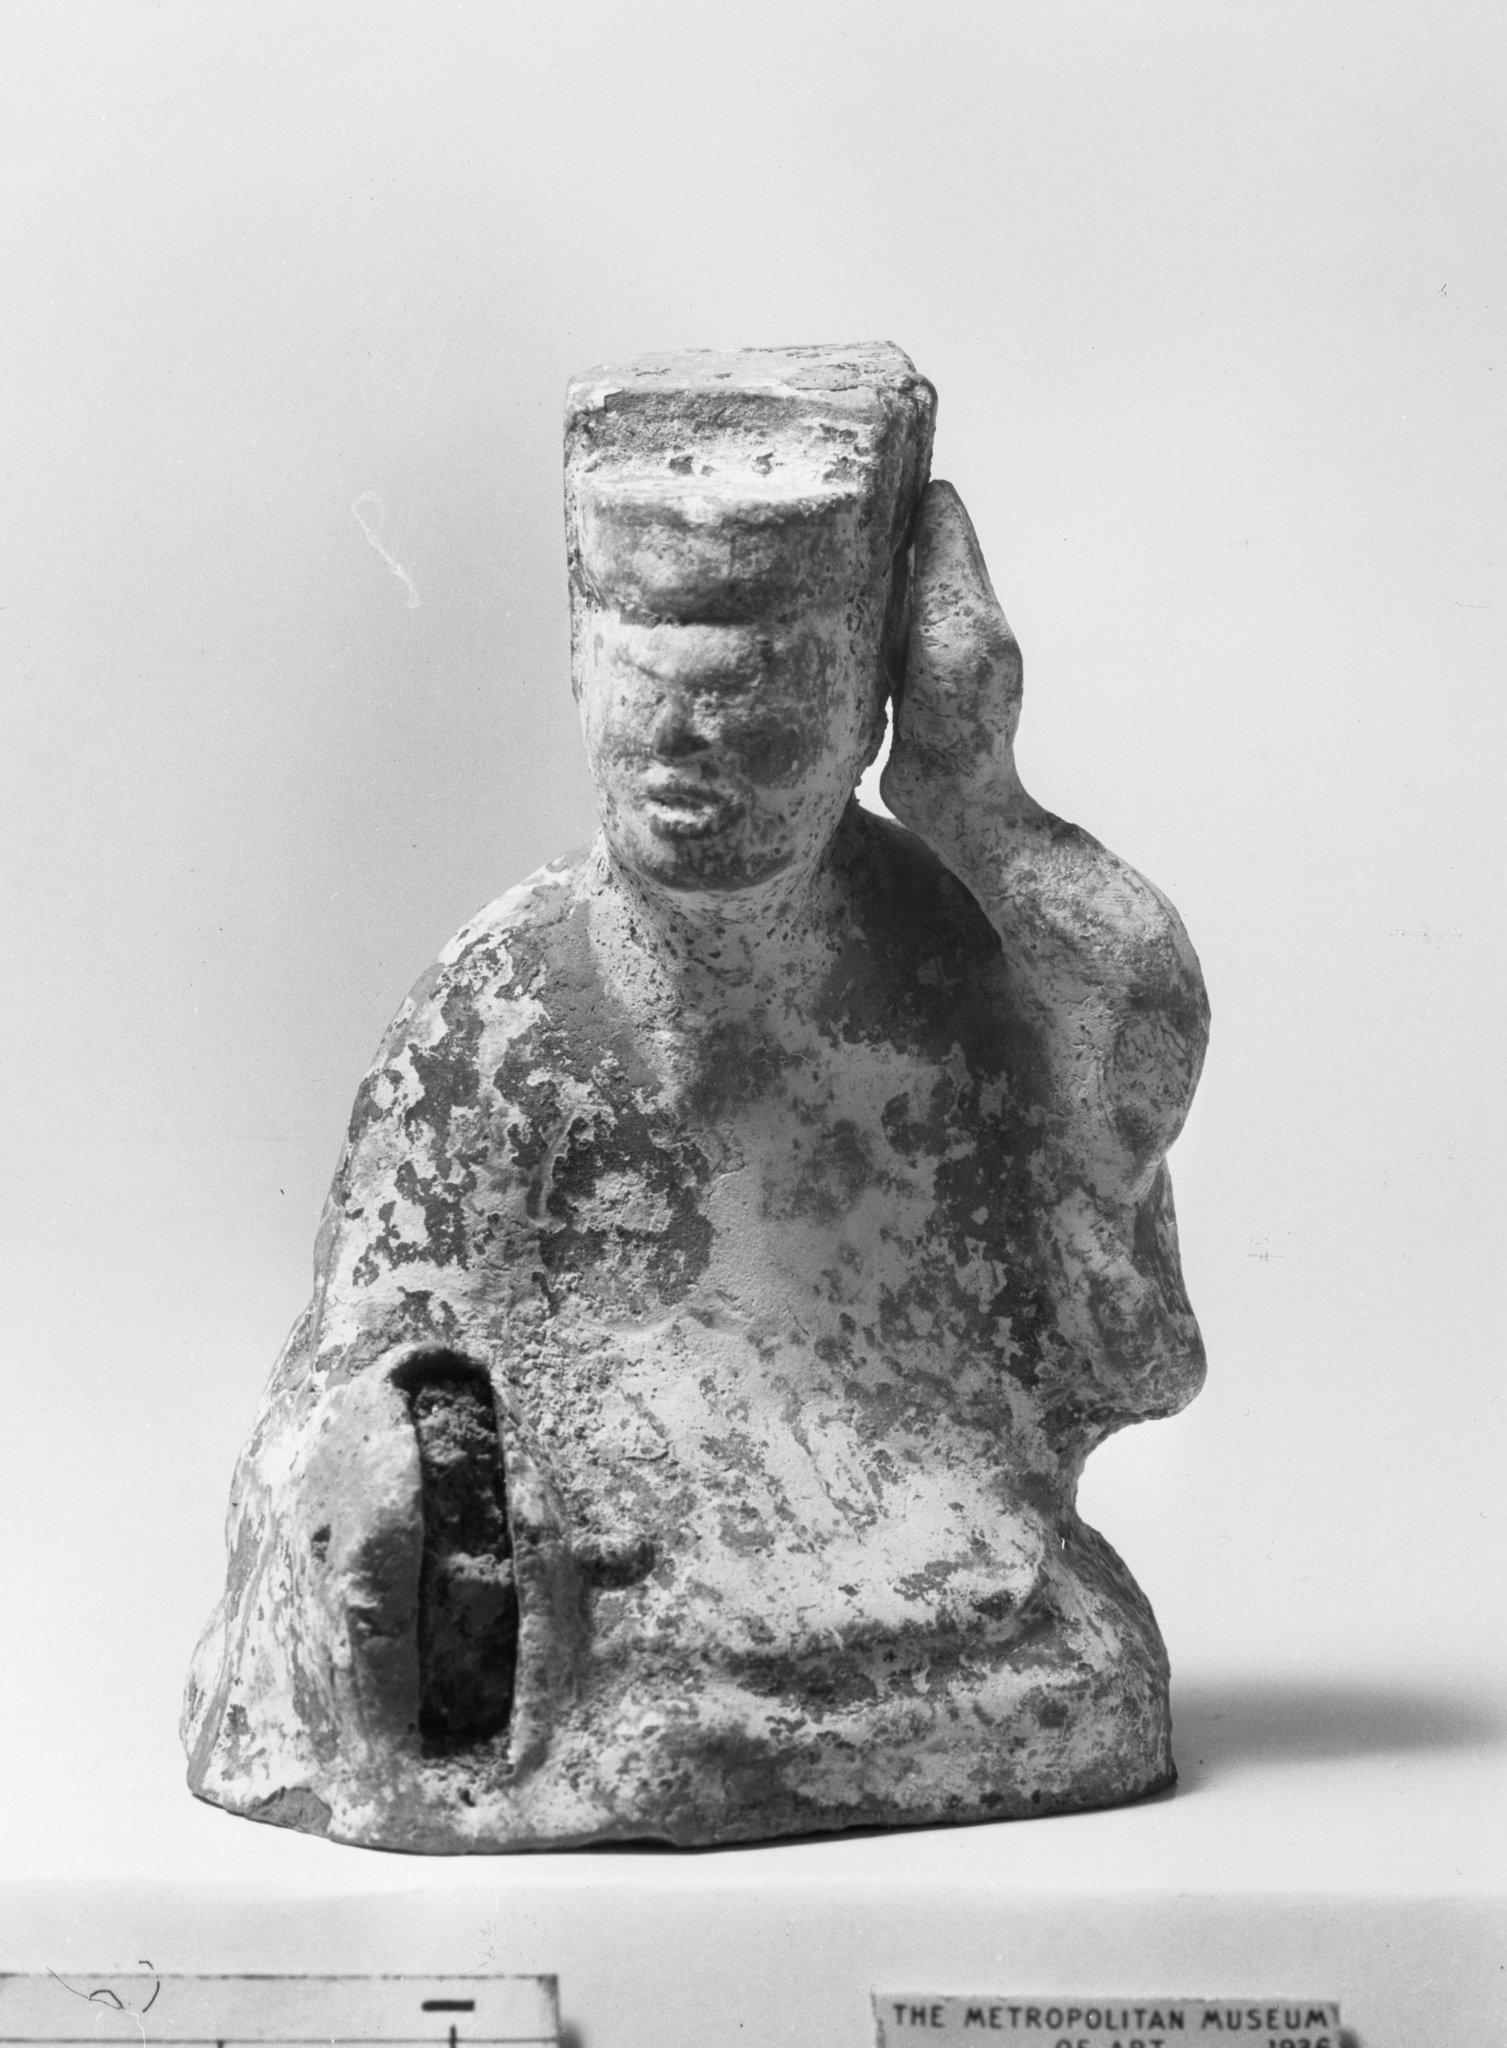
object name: figure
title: Figure of a Seated Musician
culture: chinese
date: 206 BCE-220 CE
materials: pottery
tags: human figures